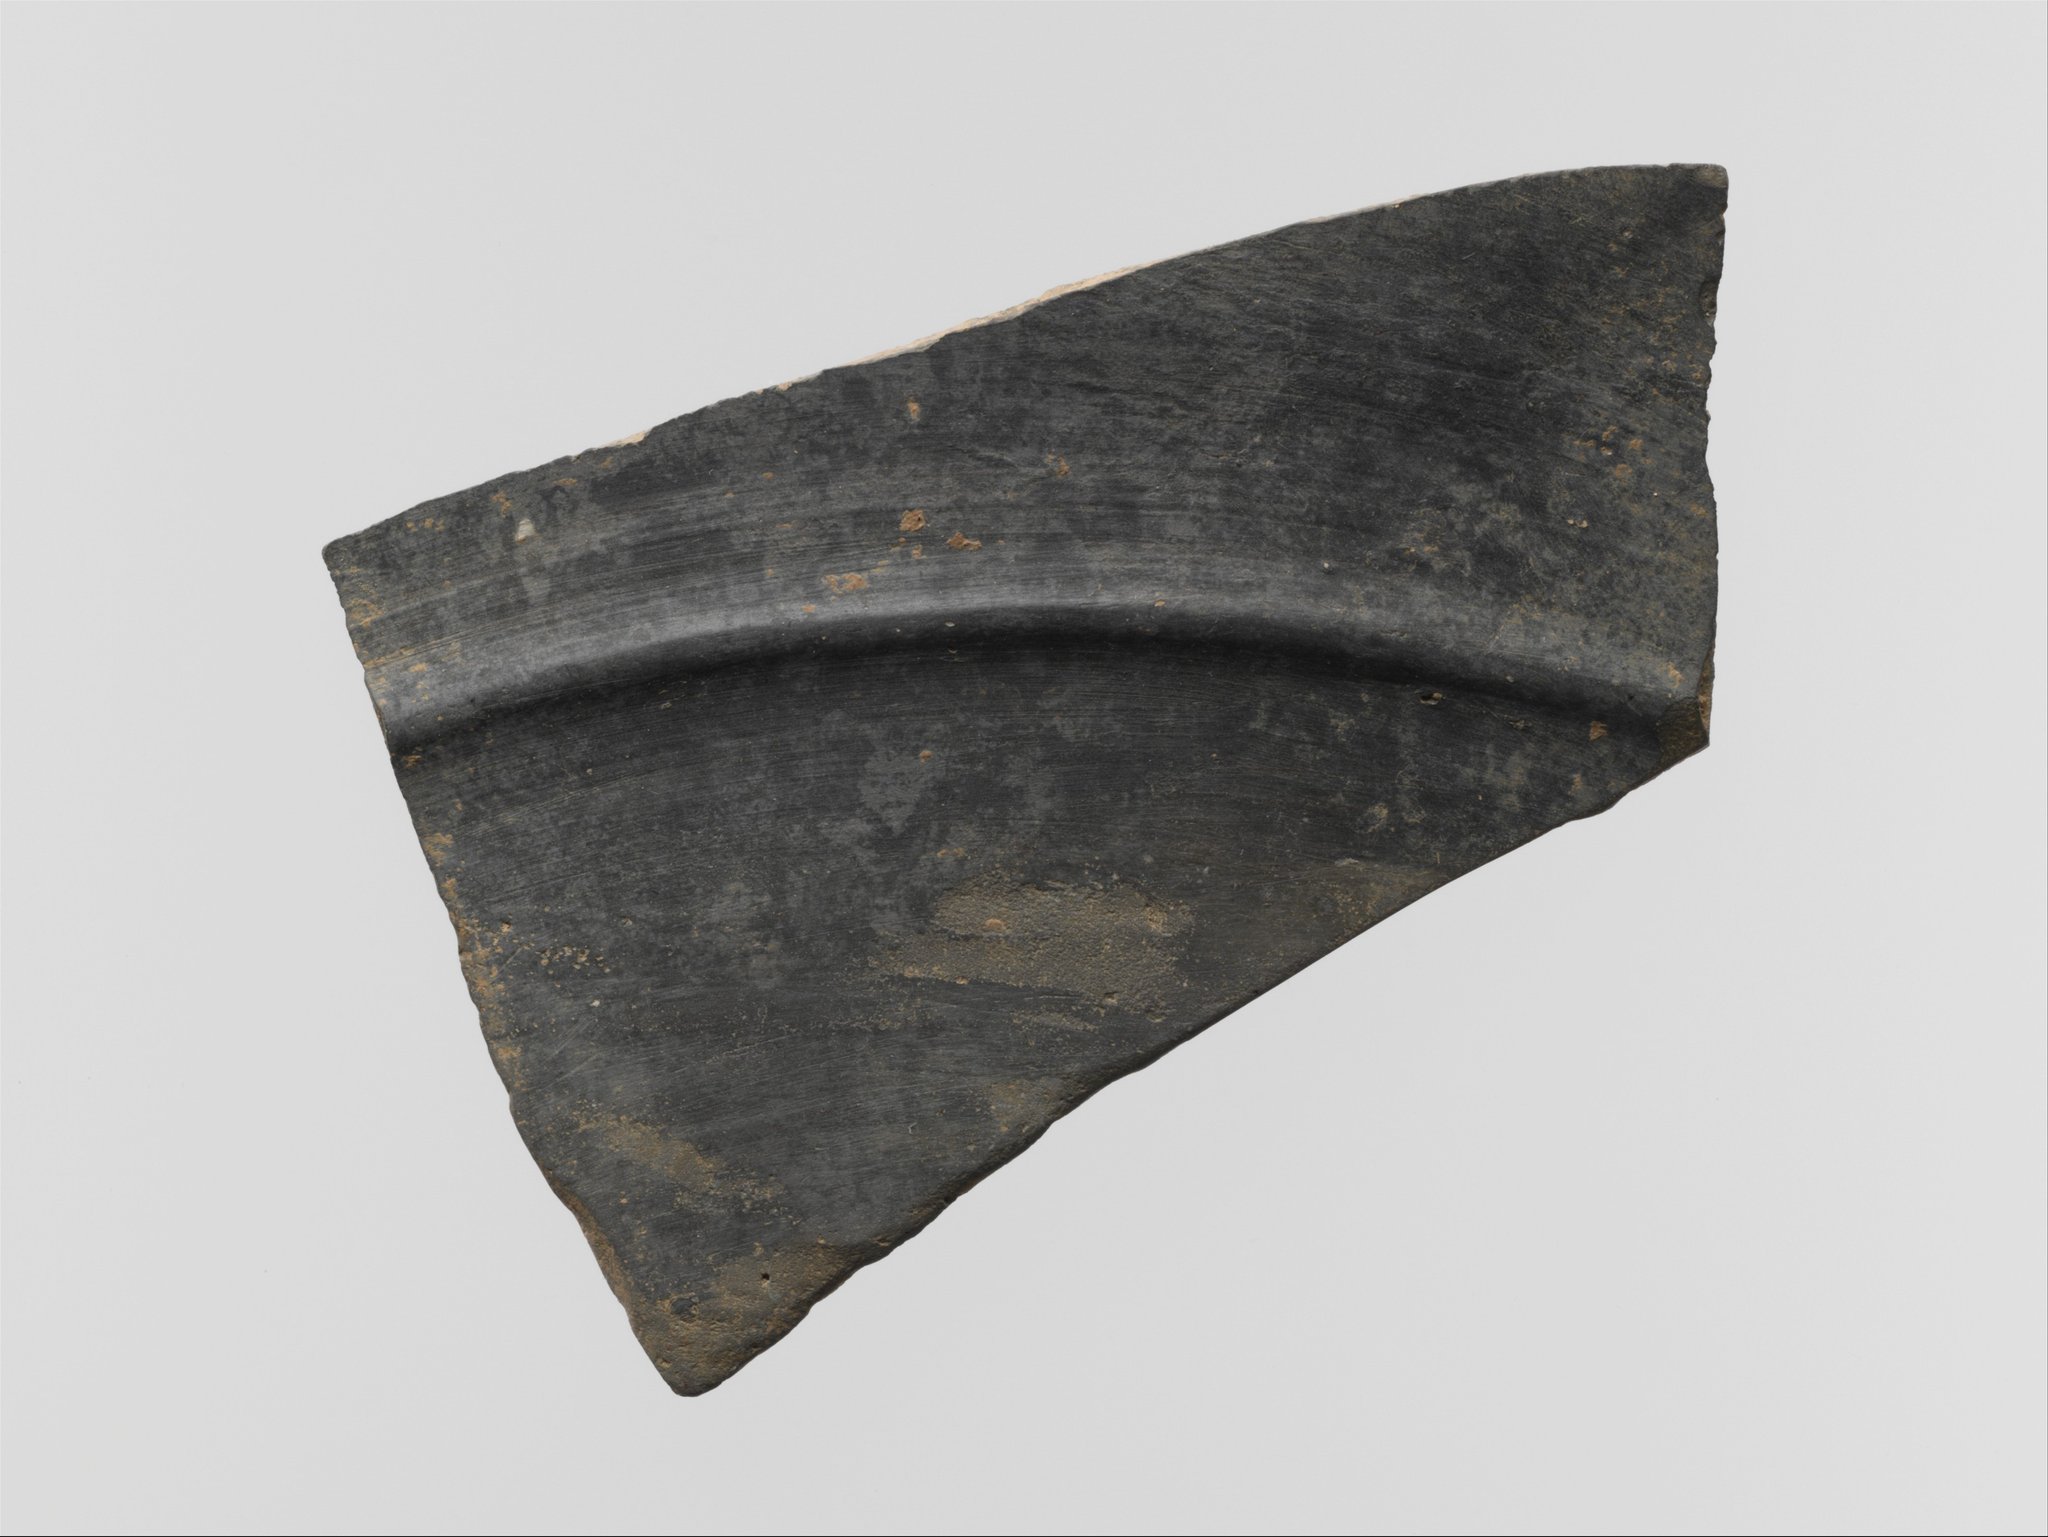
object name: vase fragment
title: Terracotta fragment of a bowl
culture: helladic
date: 2100-1900 BCE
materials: terracotta